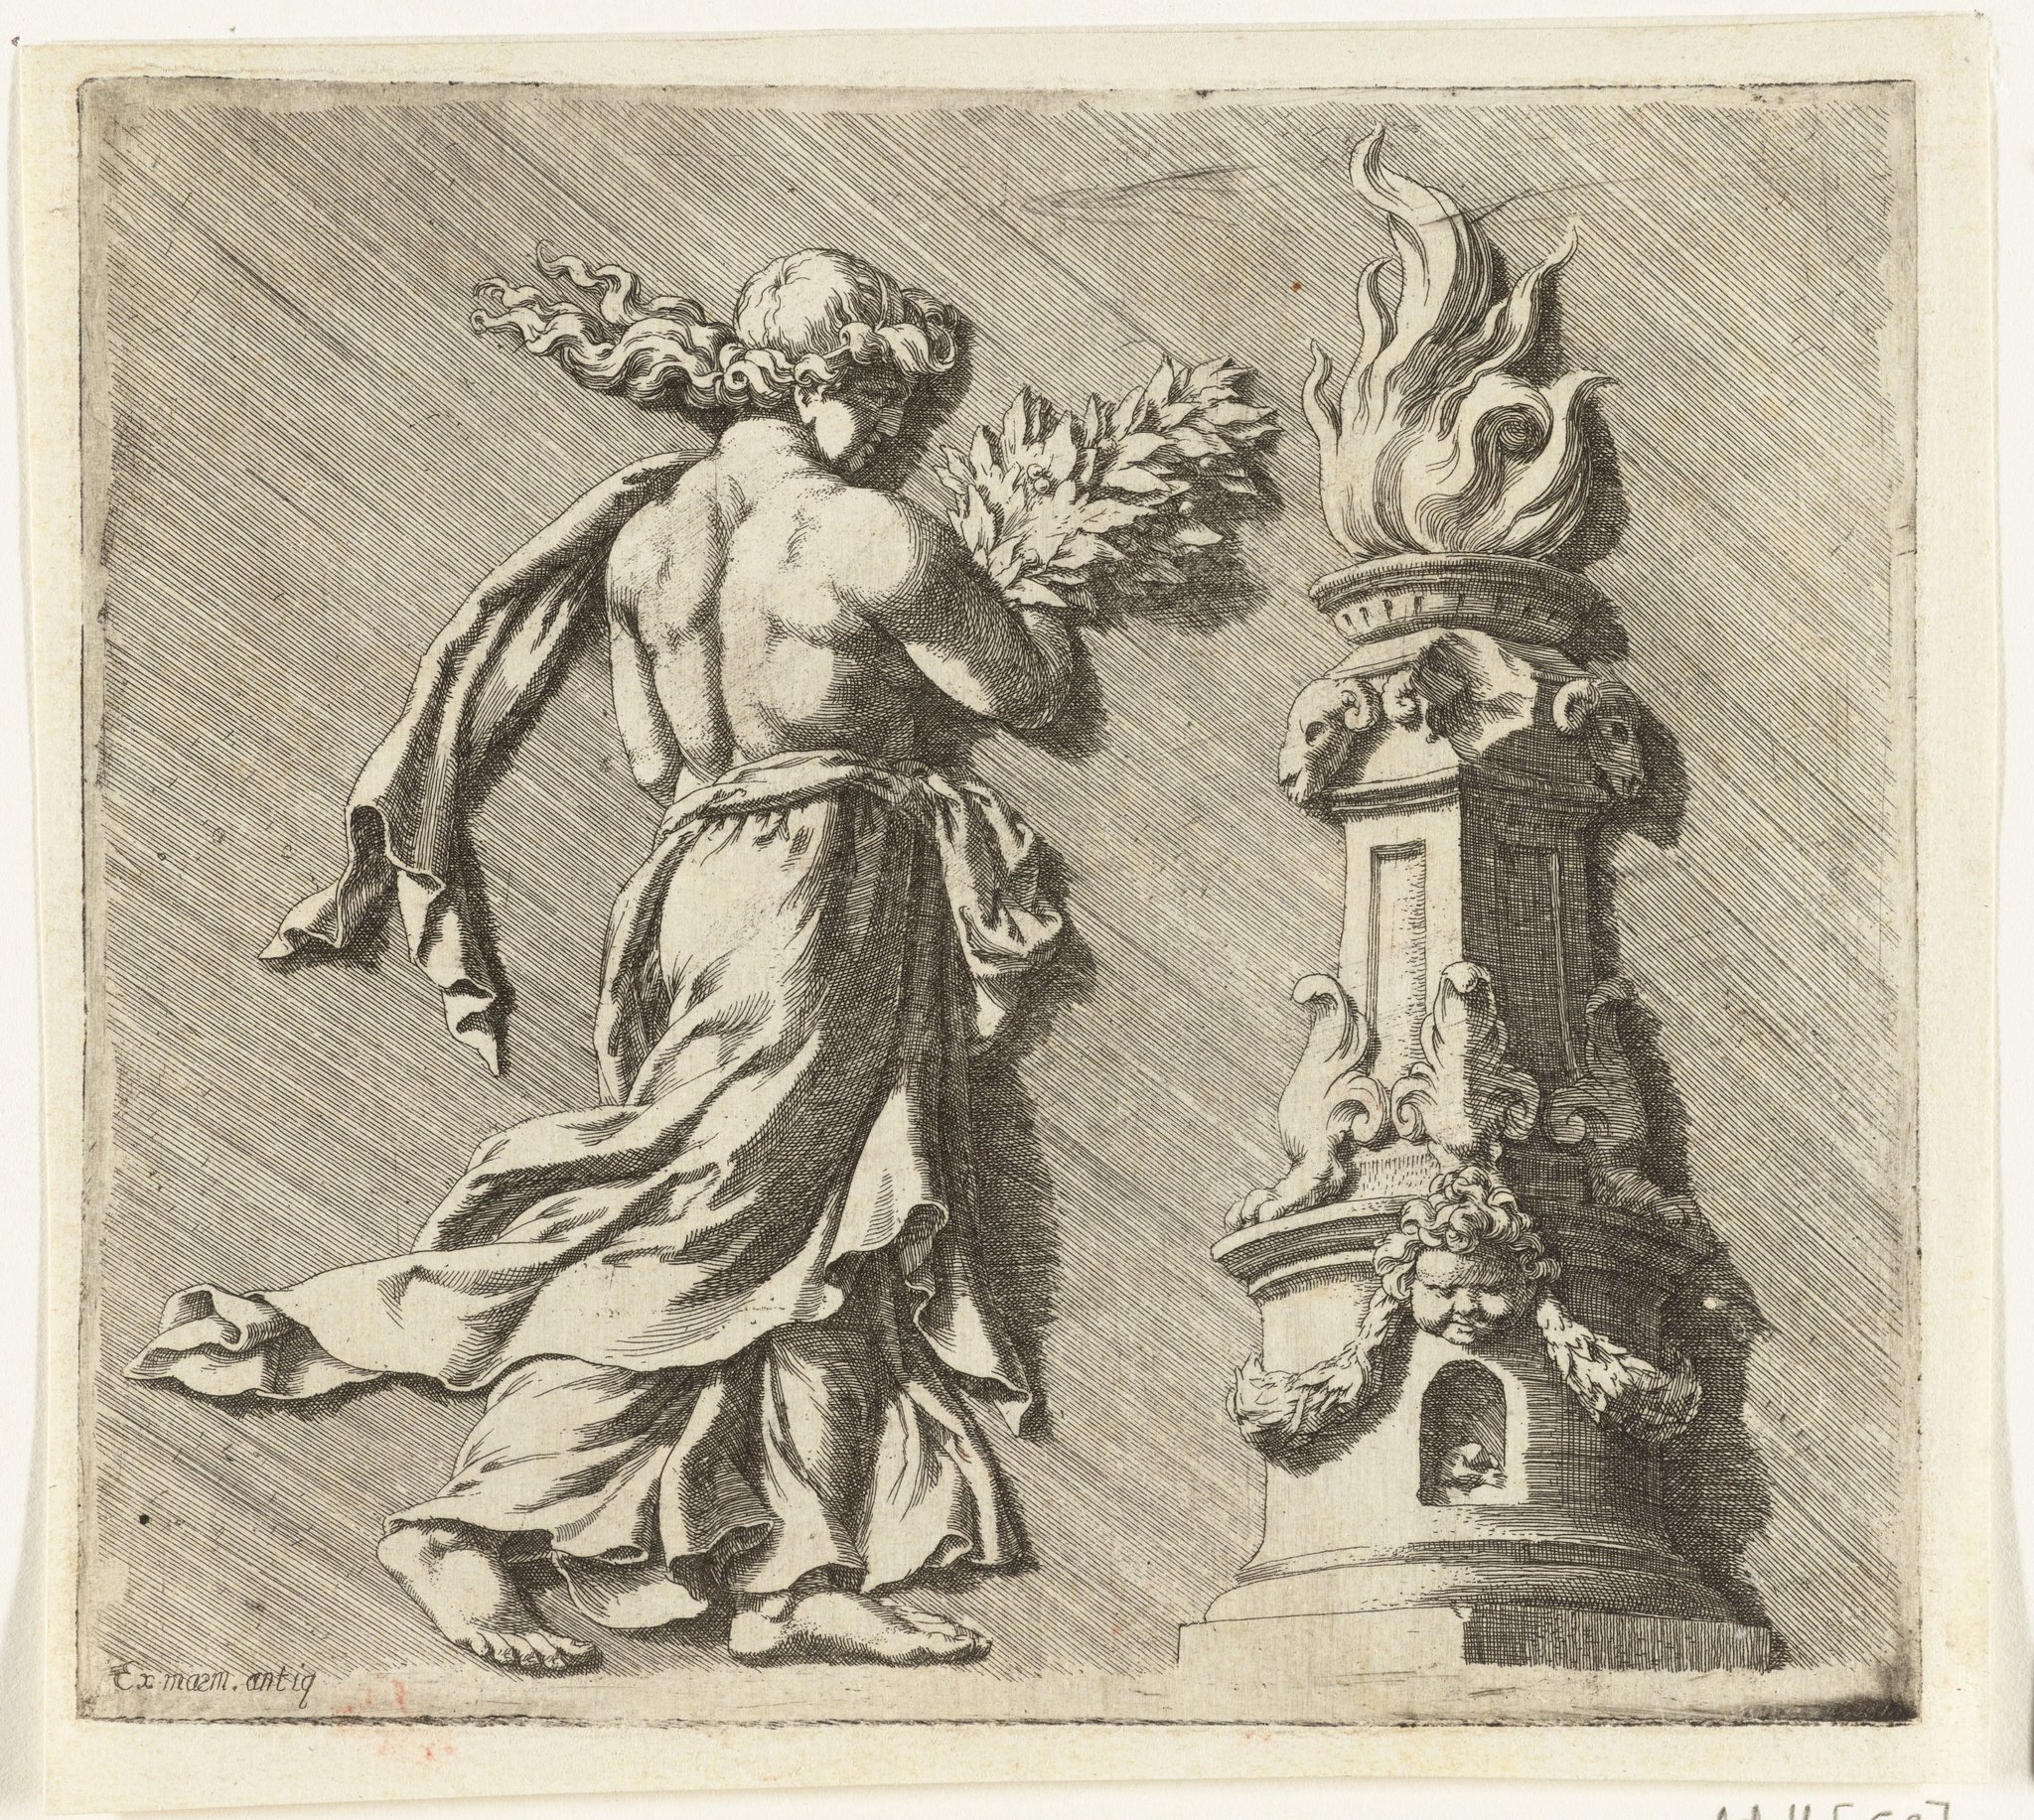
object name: print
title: Pomona bij een brandende offerzuil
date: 1638-1671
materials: paper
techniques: etching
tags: pomona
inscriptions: collector's mark: Lugt 2228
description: De godin Pomona met een bundel takken met vruchten in haar arm loopt naar een brandende offerzuil toe.